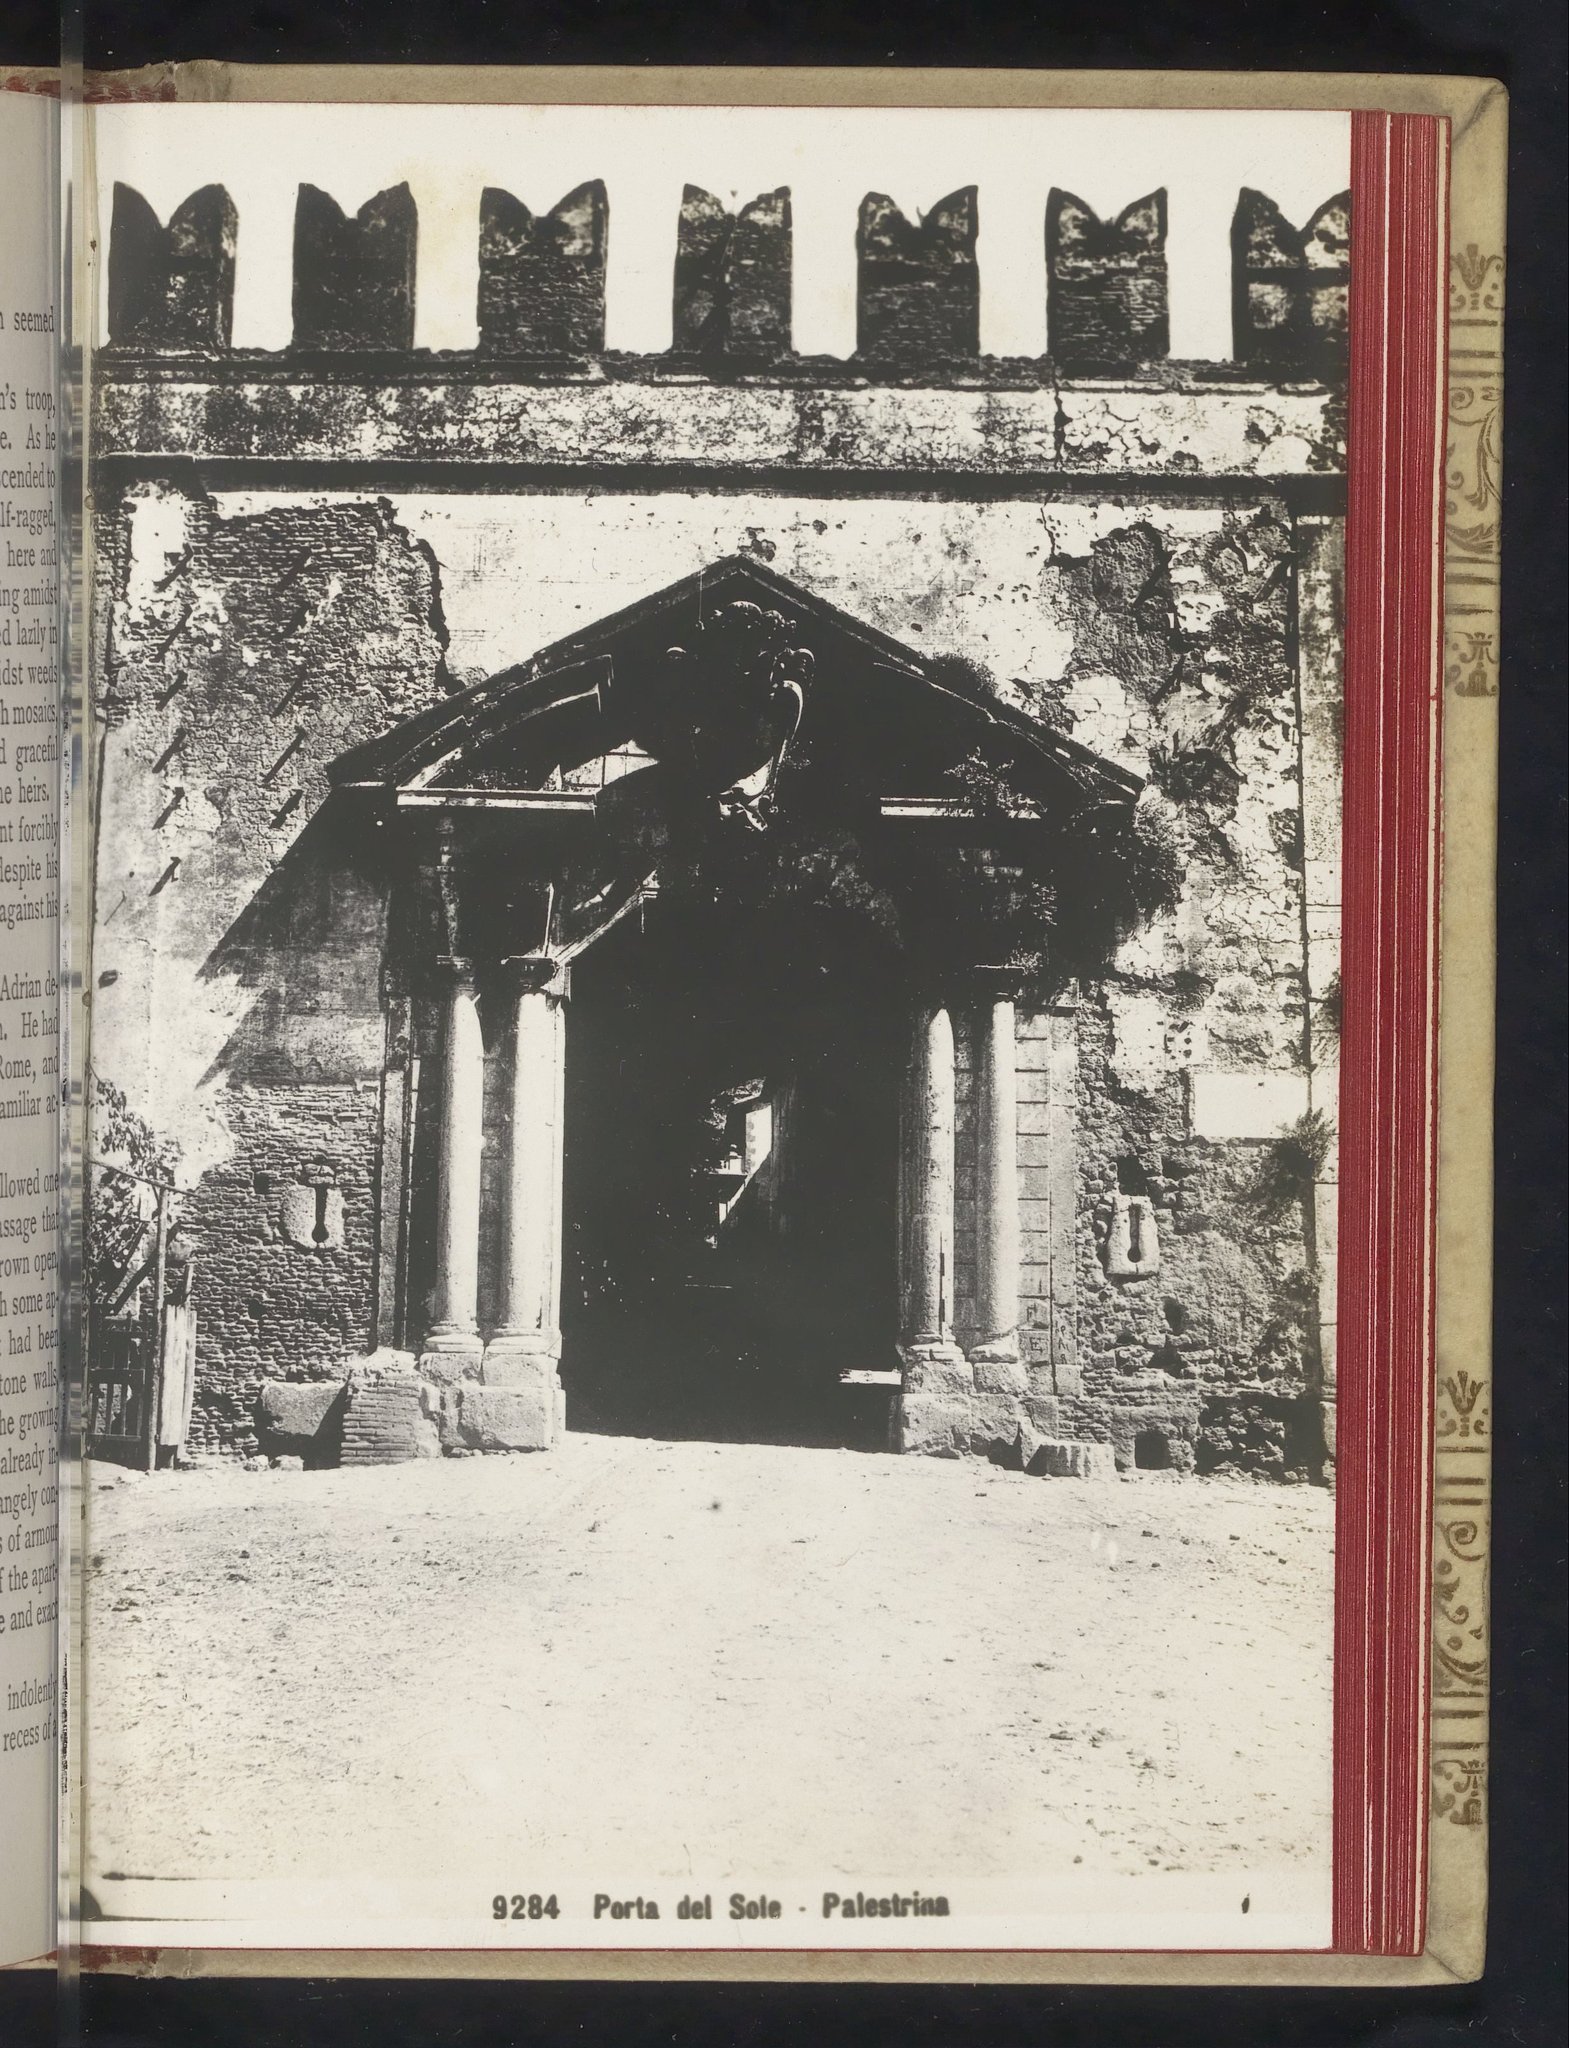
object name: photograph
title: Porta del Sole te Palestrina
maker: Anonymous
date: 1895-1915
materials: photographic support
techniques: gelatin silver print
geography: palestrina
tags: gate, entrance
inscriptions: number: ‘9284’